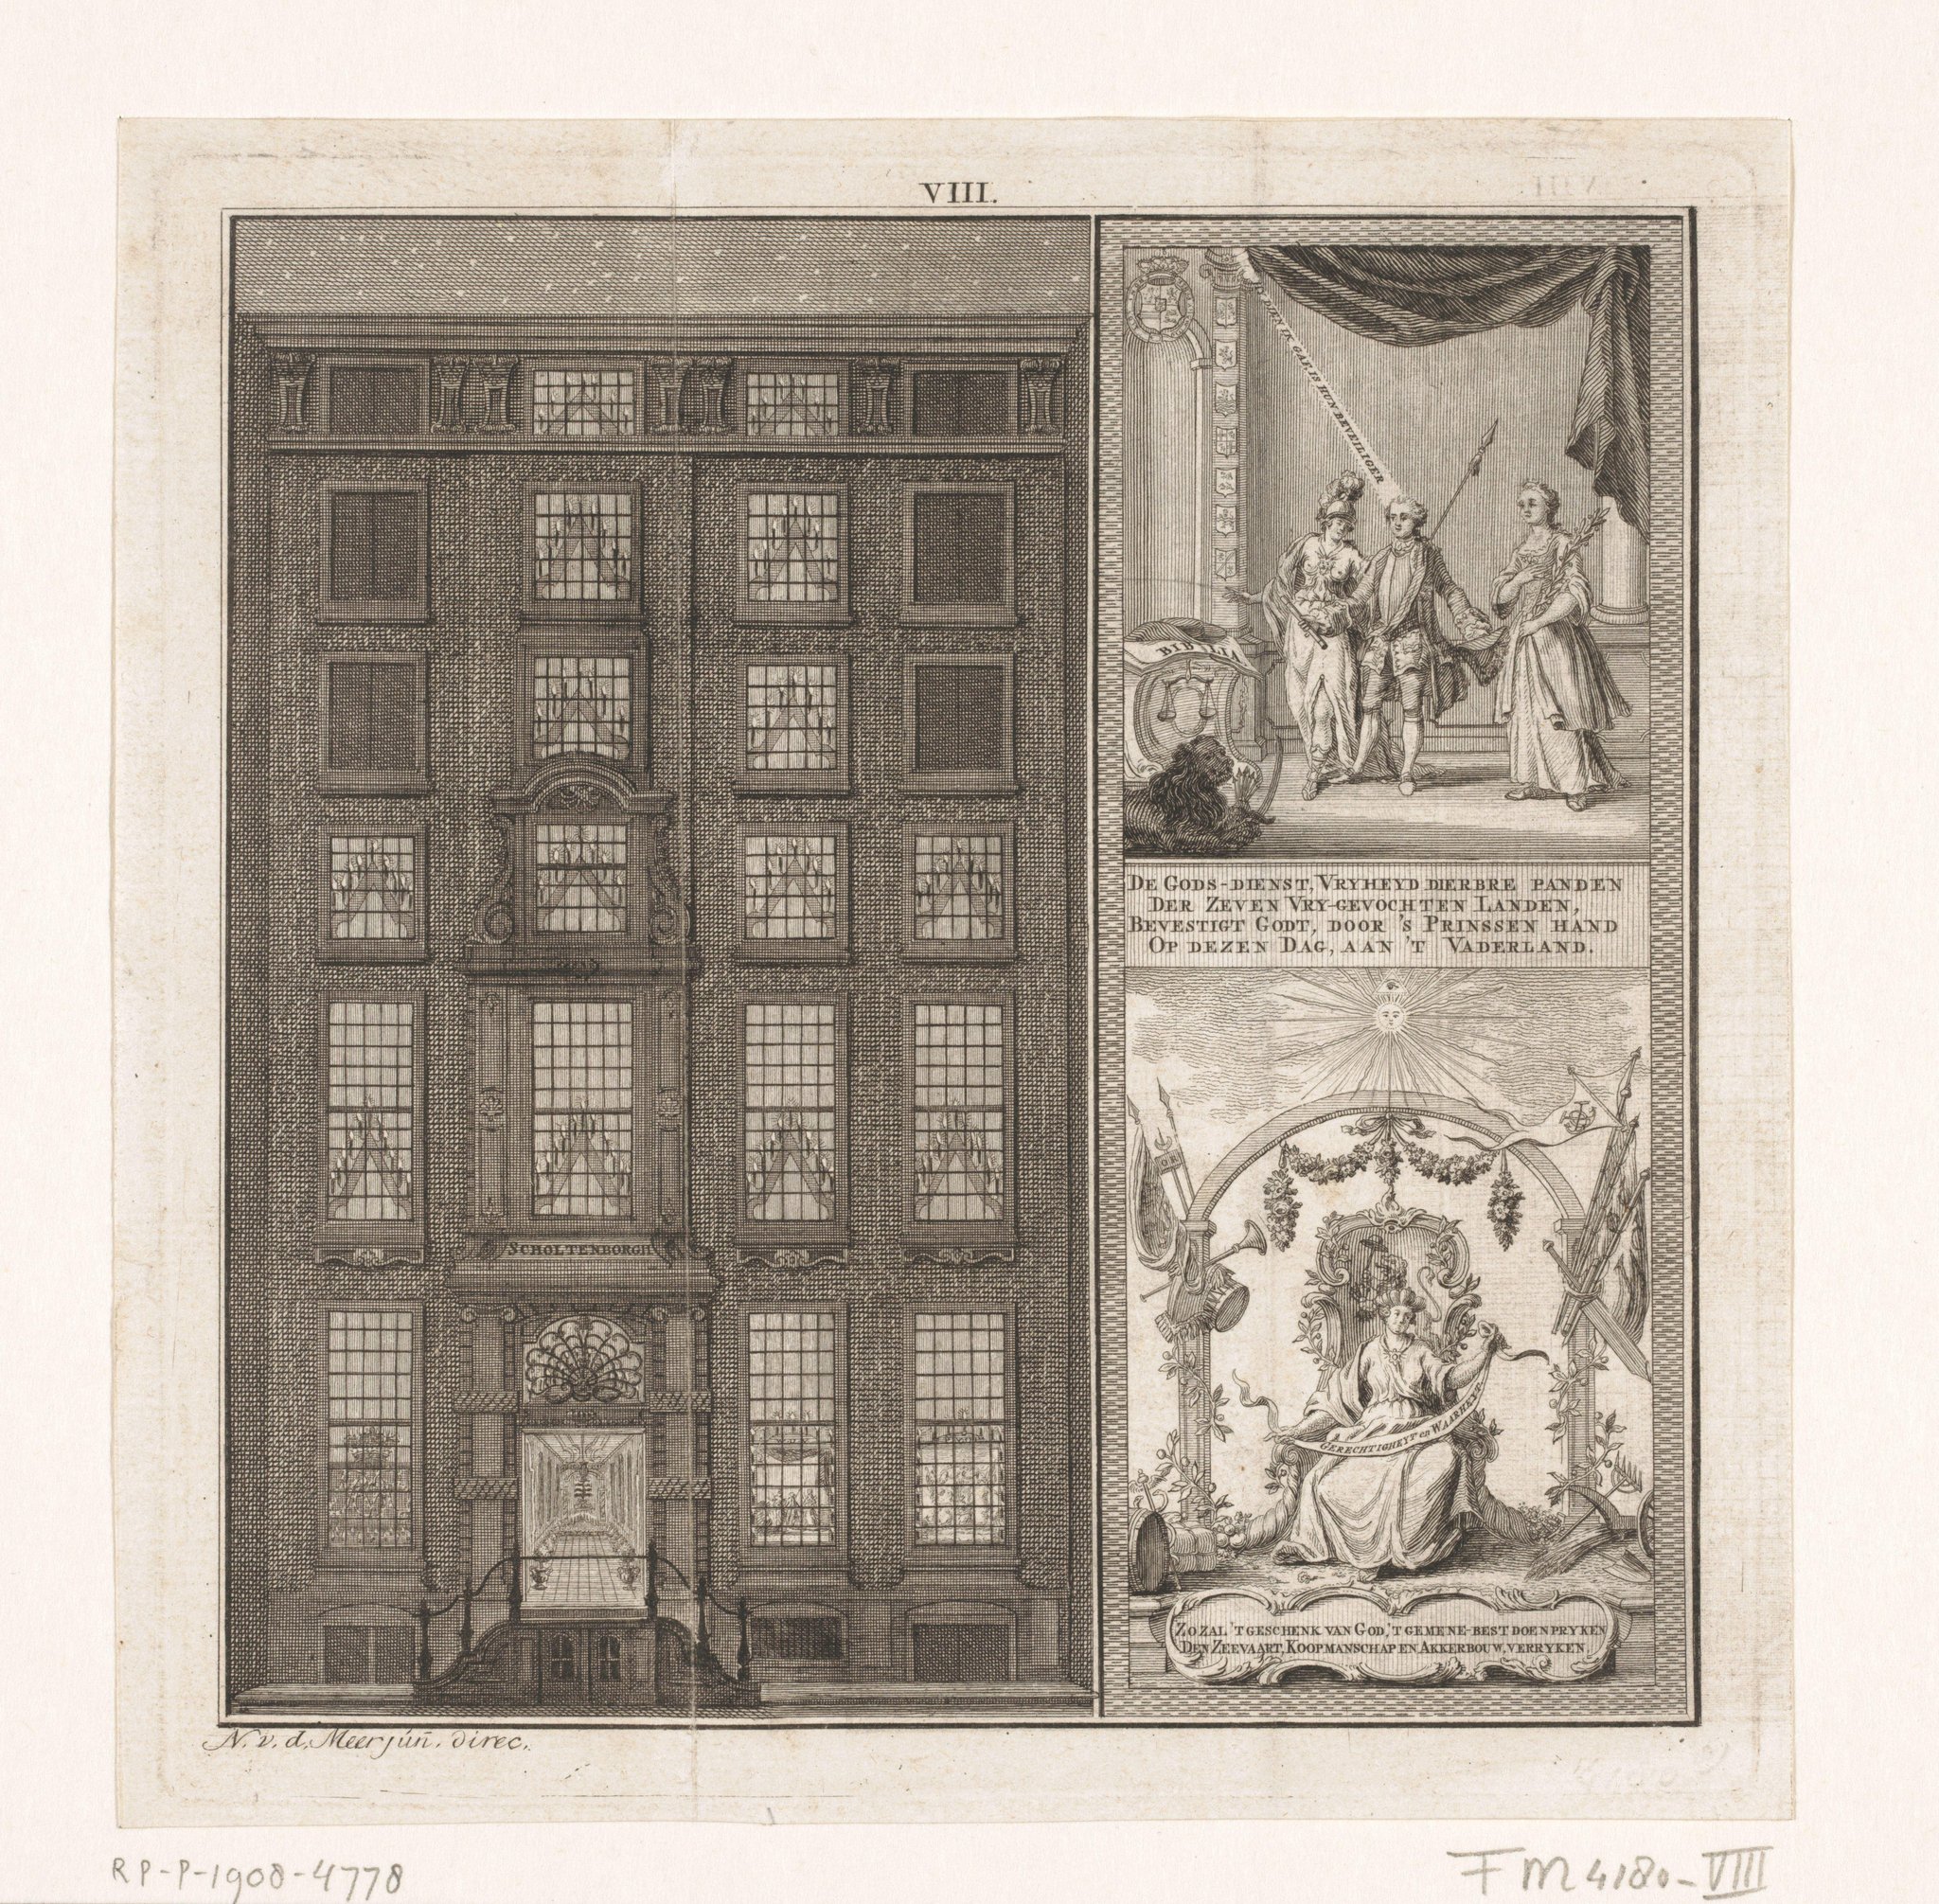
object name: print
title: Illuminatië van het huis van de heer J.A. Scholten van Aschat te Amsterdam, 1766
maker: noach van der meer (ii)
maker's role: draughtsman, print maker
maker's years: 1741-1822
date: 1774-1776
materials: paper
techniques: engraving, etching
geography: northern netherlands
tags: the hague, william v (prince of orange), bonfire, fire-works (+ illumination, fire-works ~ festive activities)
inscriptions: collector's mark: Lugt 2228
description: Gebruikt als illustratie in: Verlicht en juichend Nederland, of Vaderlandsche geschiedenissen; van het tijdstip, dat (...) den heere prinse van Oranje (...) digniteiten (...) heeft aenvaerd. Leiden: Cornelis van Hoogeveen junior, Cornelis van Leiden, 1776, p. 236/237.